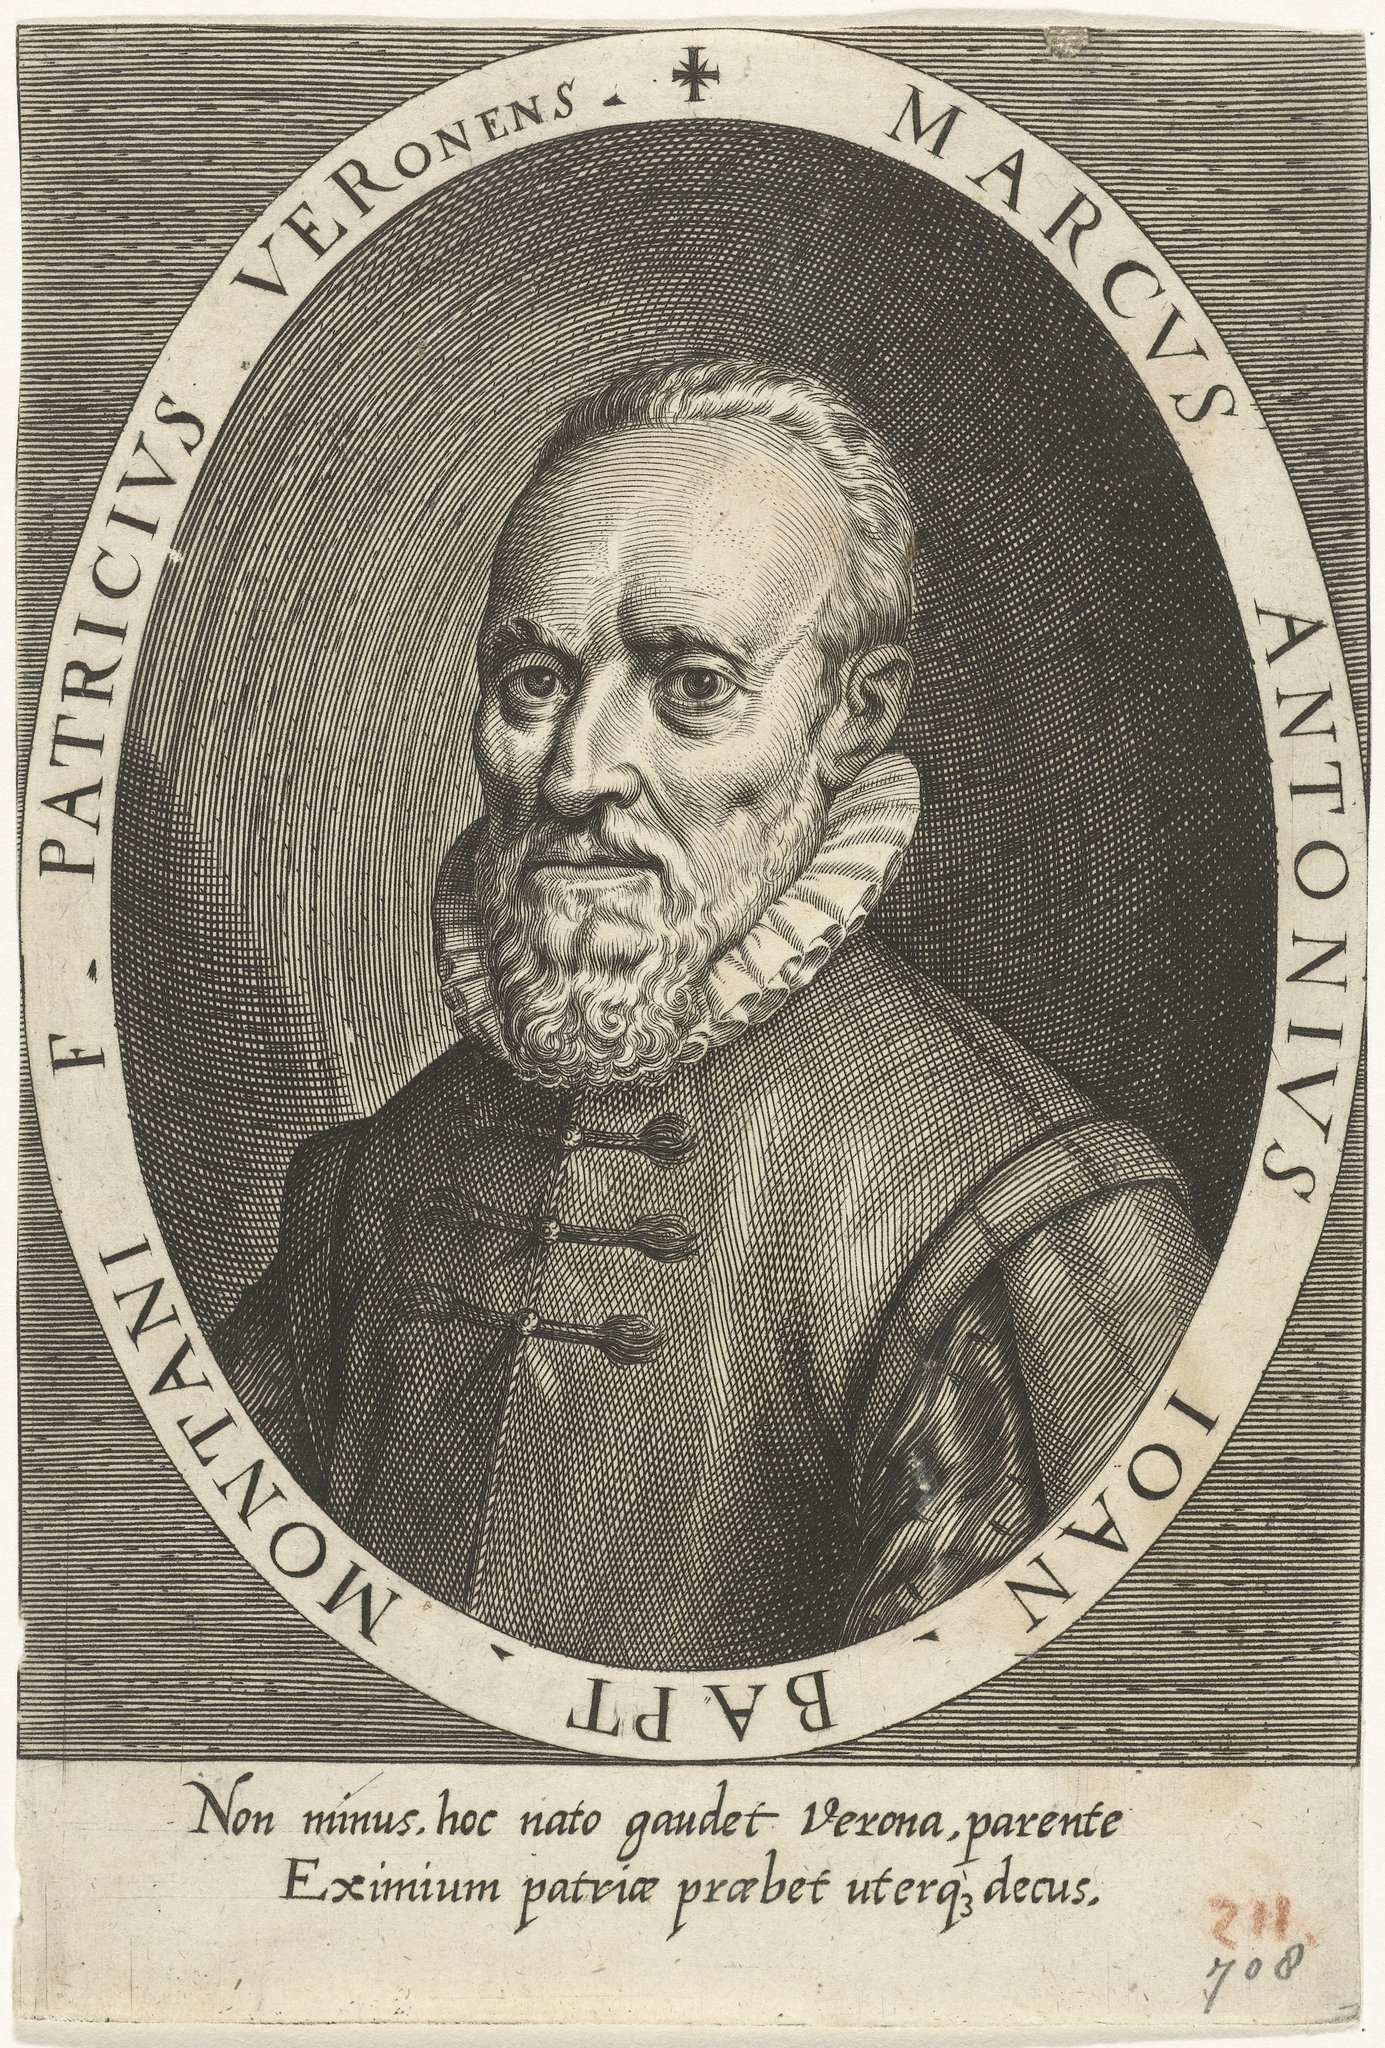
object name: print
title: Portret van Marcus Antonius Montanus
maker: dominicus custos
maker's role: print maker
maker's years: 1560-1615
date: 1579-1615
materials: paper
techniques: engraving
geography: augsburg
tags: arts, marcus antonius montanus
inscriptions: collector's mark: Lugt 2228